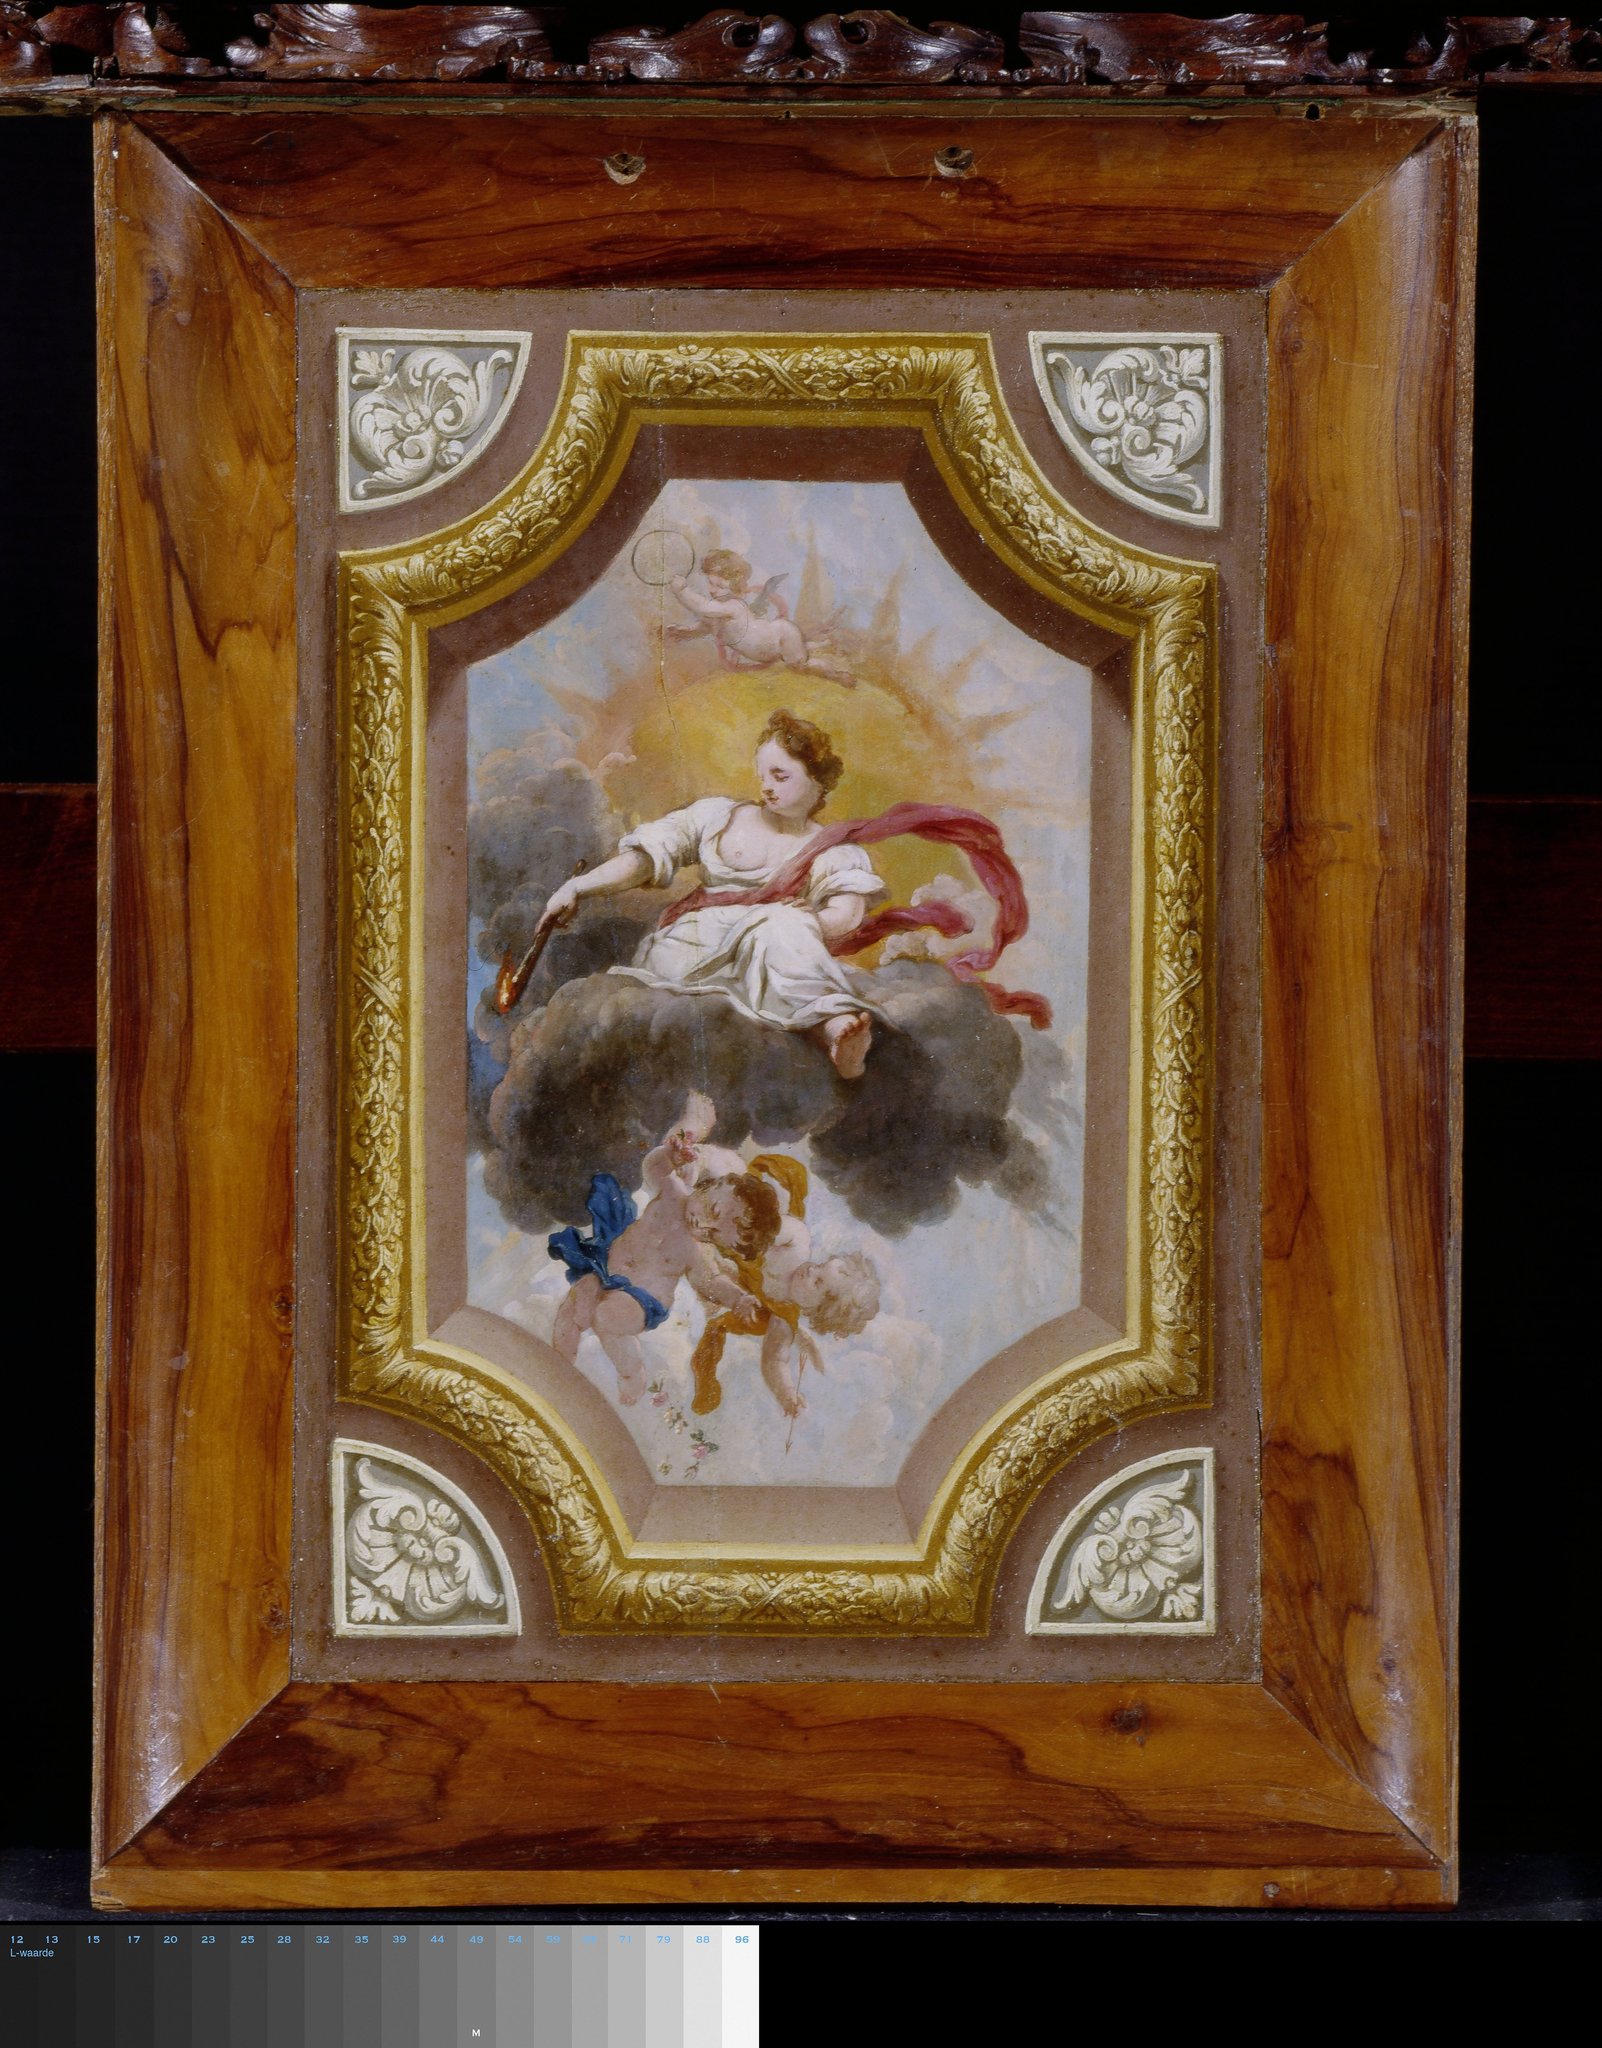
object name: miniature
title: Aurora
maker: johannes voorhout (i)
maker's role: draughtsman, painter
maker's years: 1647-1723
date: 1690-1710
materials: oil, paint, panel